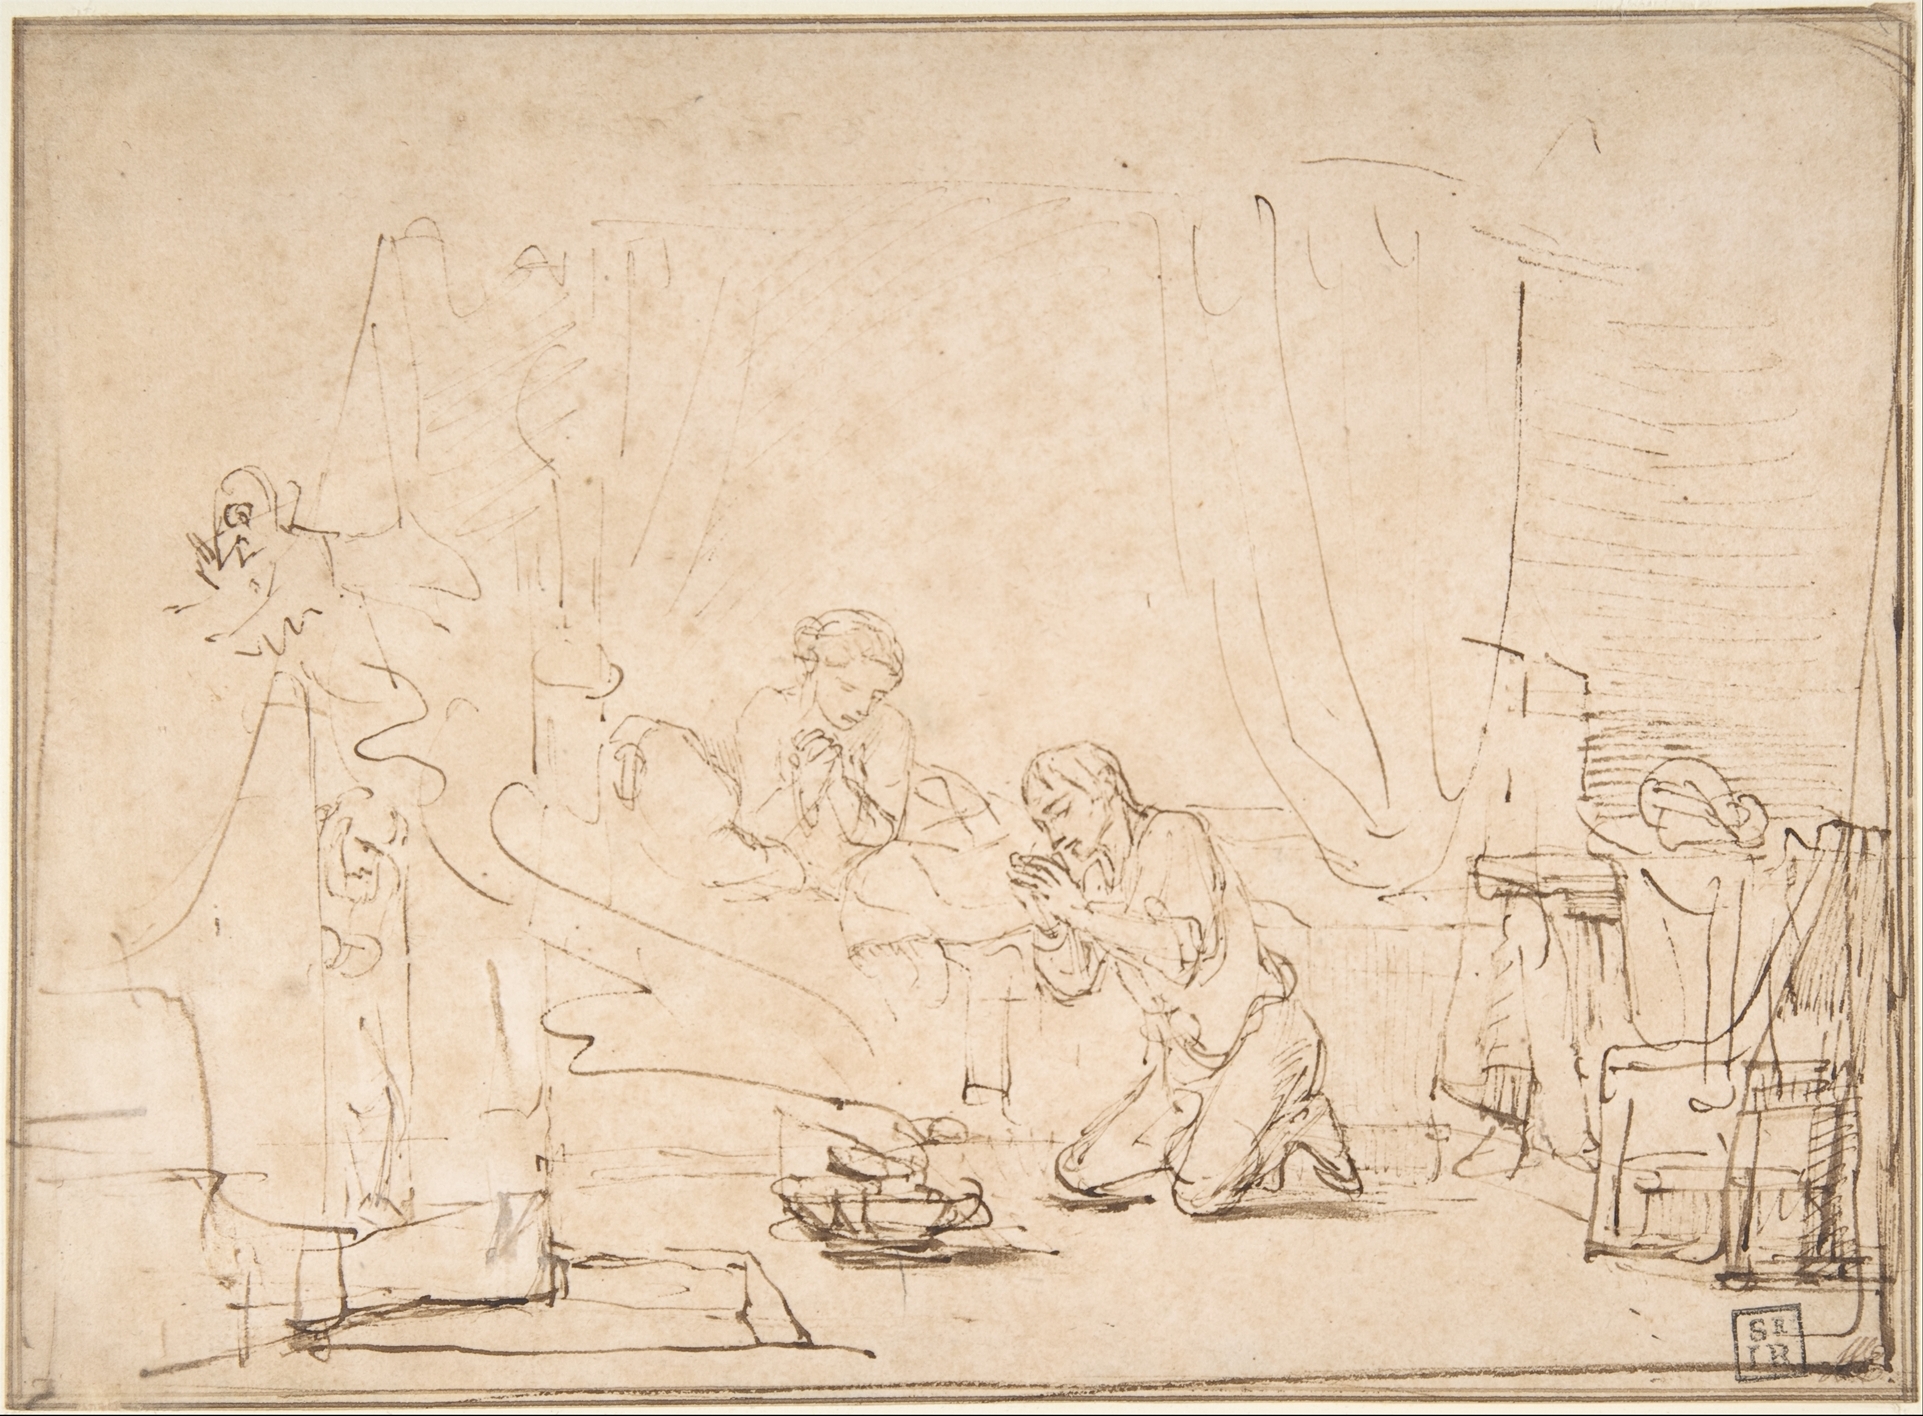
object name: drawing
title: The Wedding Night of Tobias and Sarah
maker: rembrandt van rijn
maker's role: artist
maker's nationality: dutch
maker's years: 1606-1669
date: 1640-1649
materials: ink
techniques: brush, pen, wash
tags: men,women